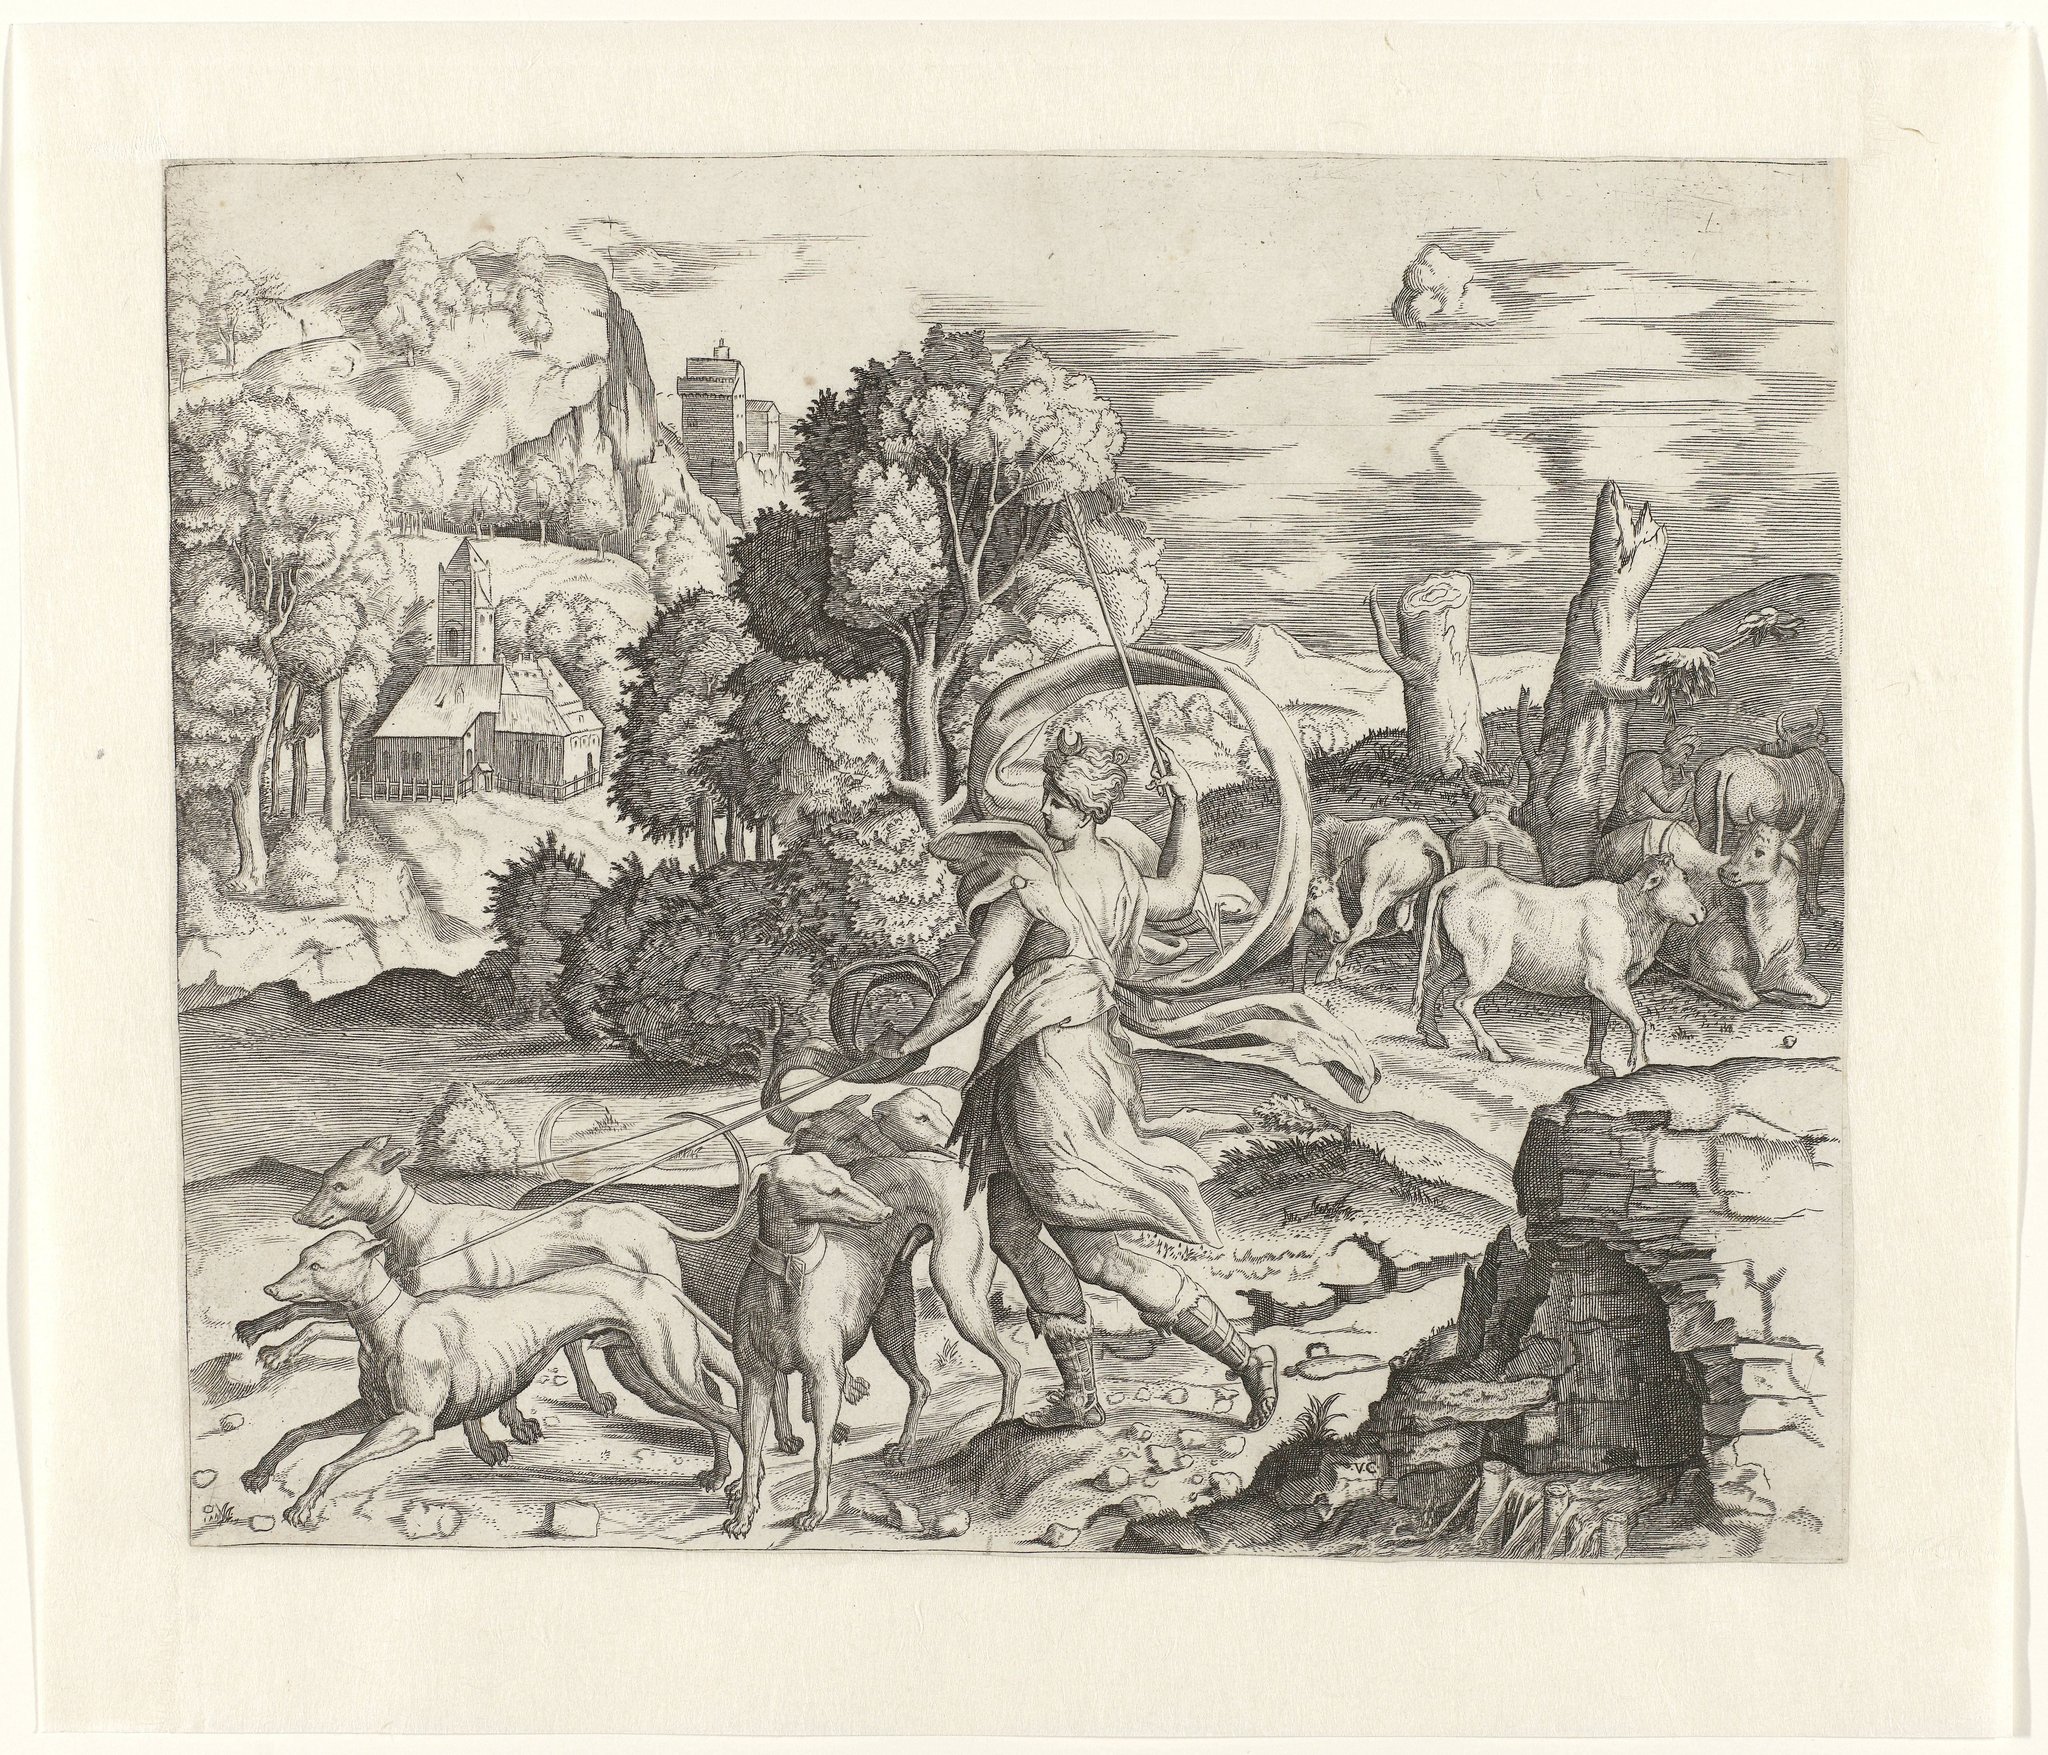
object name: print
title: Diana op jacht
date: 1510-1580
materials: paper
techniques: engraving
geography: italy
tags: diana hunting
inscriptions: collector's mark: Lugt 2228, collector's mark: Lugt 2760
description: Diana en haar honden zijn gekopieerd in dezelfde richting naar een houtsnede naar Parmigianino (TIB. 48, p. 182, nr. 10). De koeien op de achtergrond zijn gebasseerd op een tekening van Parmigianino in het British Museum te Londen (inv. nr. 1905,1110.27).